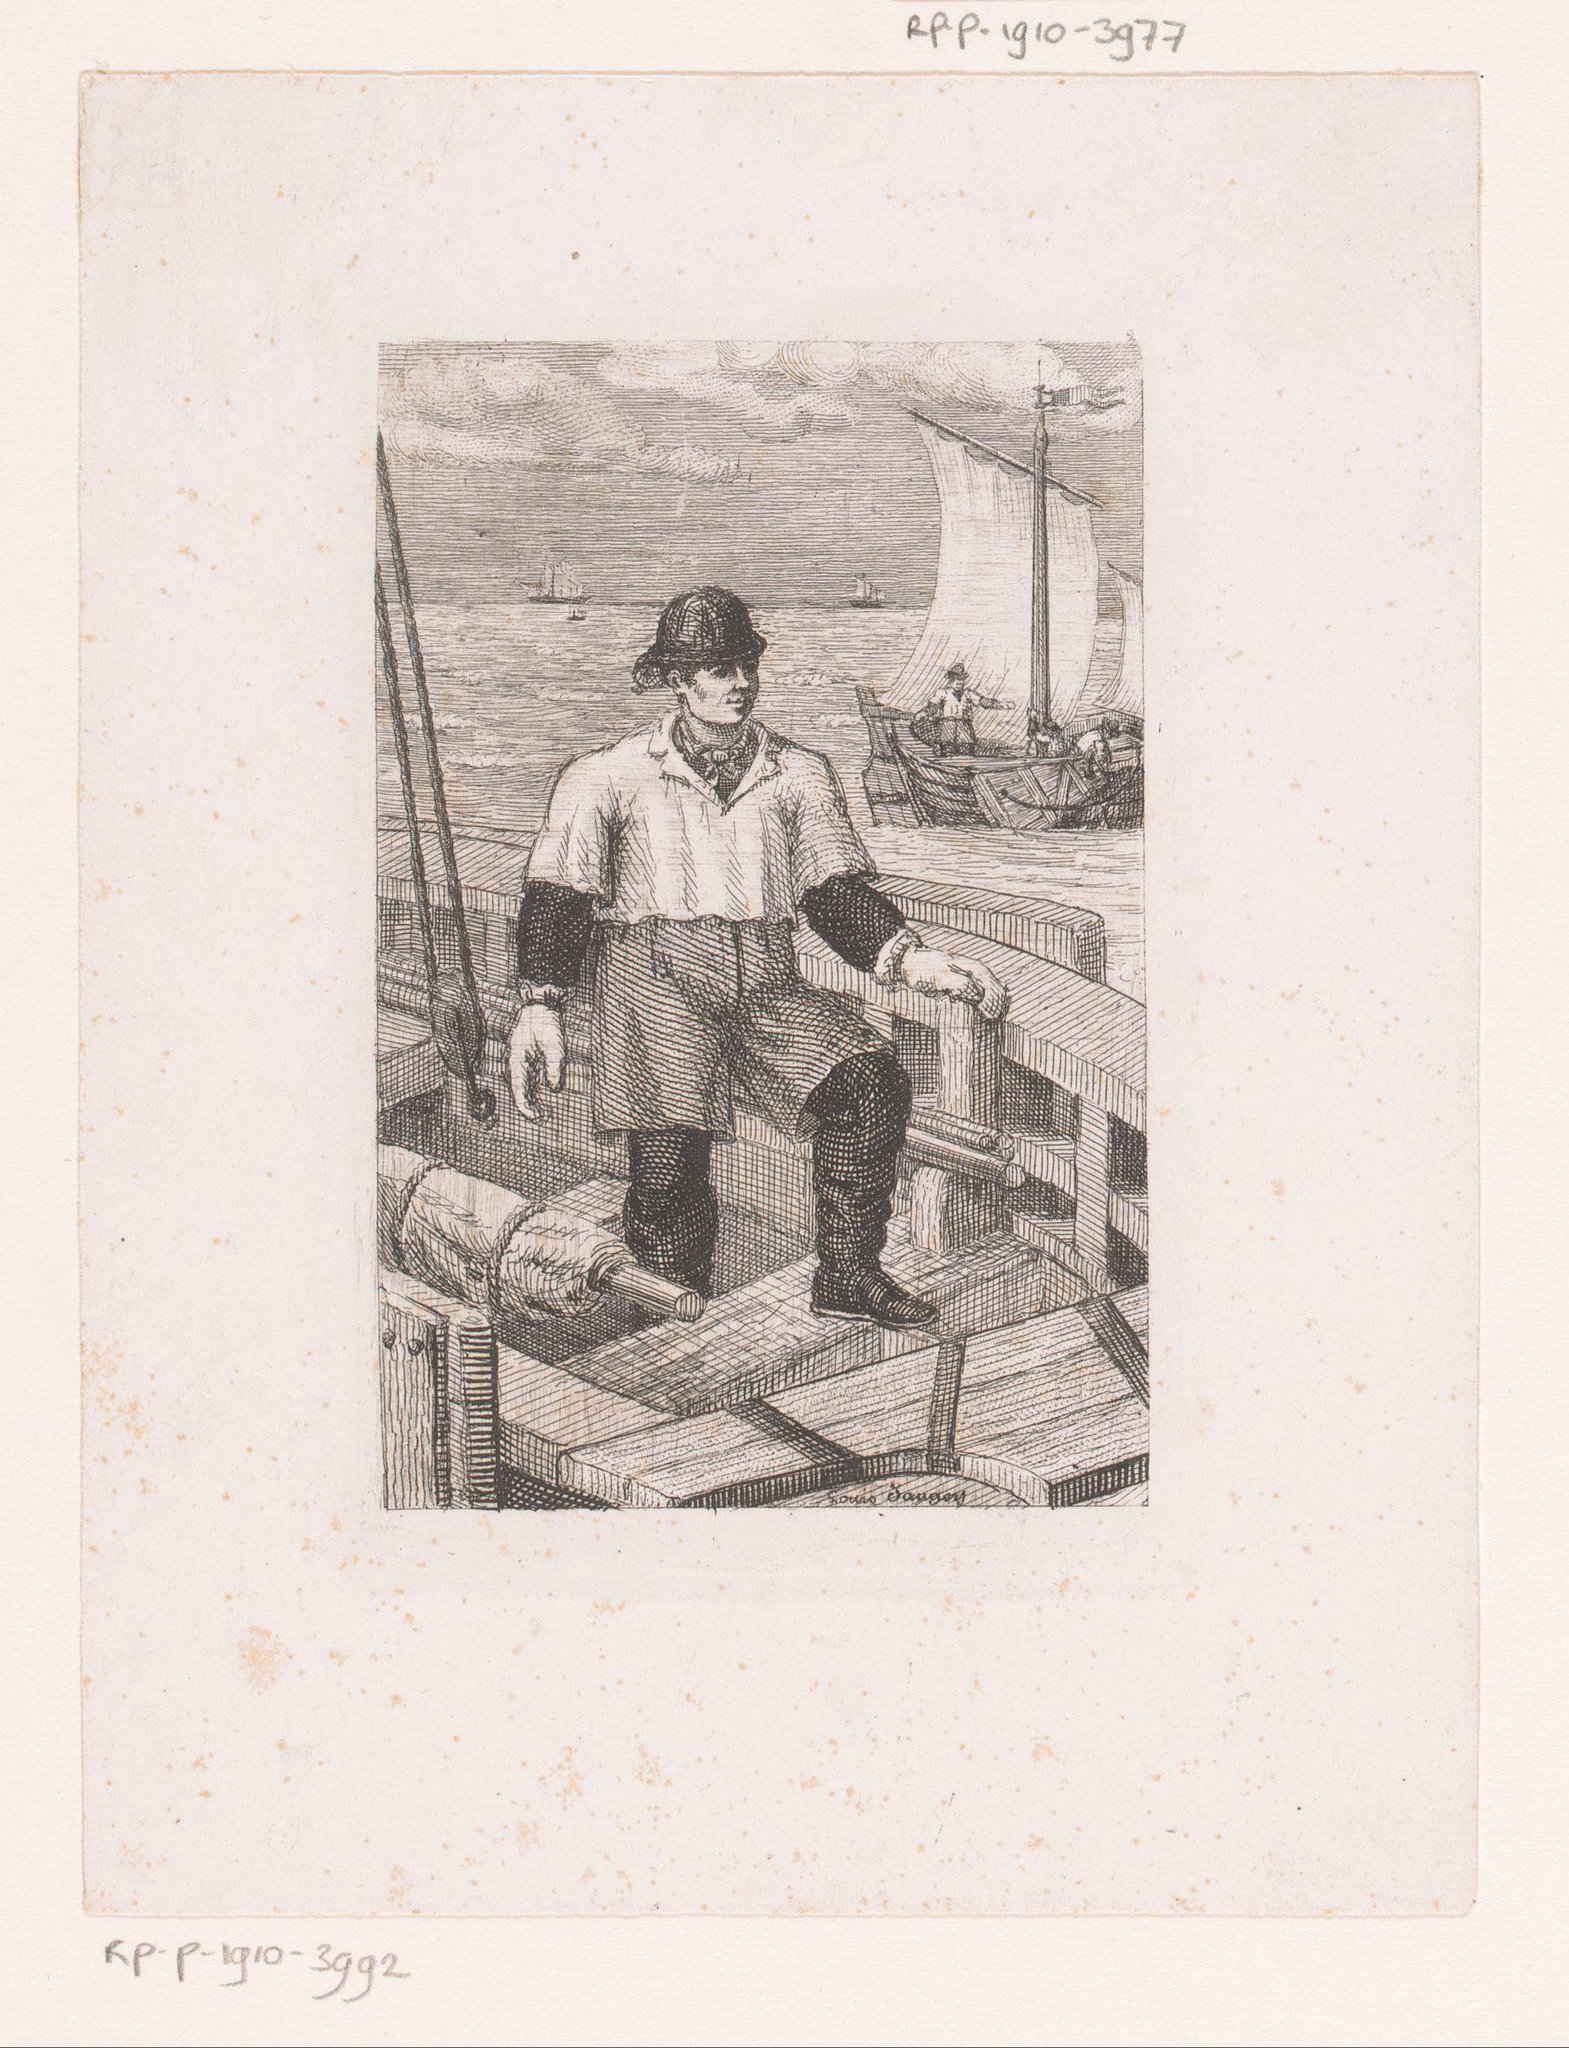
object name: print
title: Souvenir de Blankenberghe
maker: louis jaugey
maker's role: print maker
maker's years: 1837-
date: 1850-1899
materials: paper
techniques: etching, roulette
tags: sailing-ship, sailing-boat, sailor, fisherman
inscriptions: collector's mark: Lugt 2228